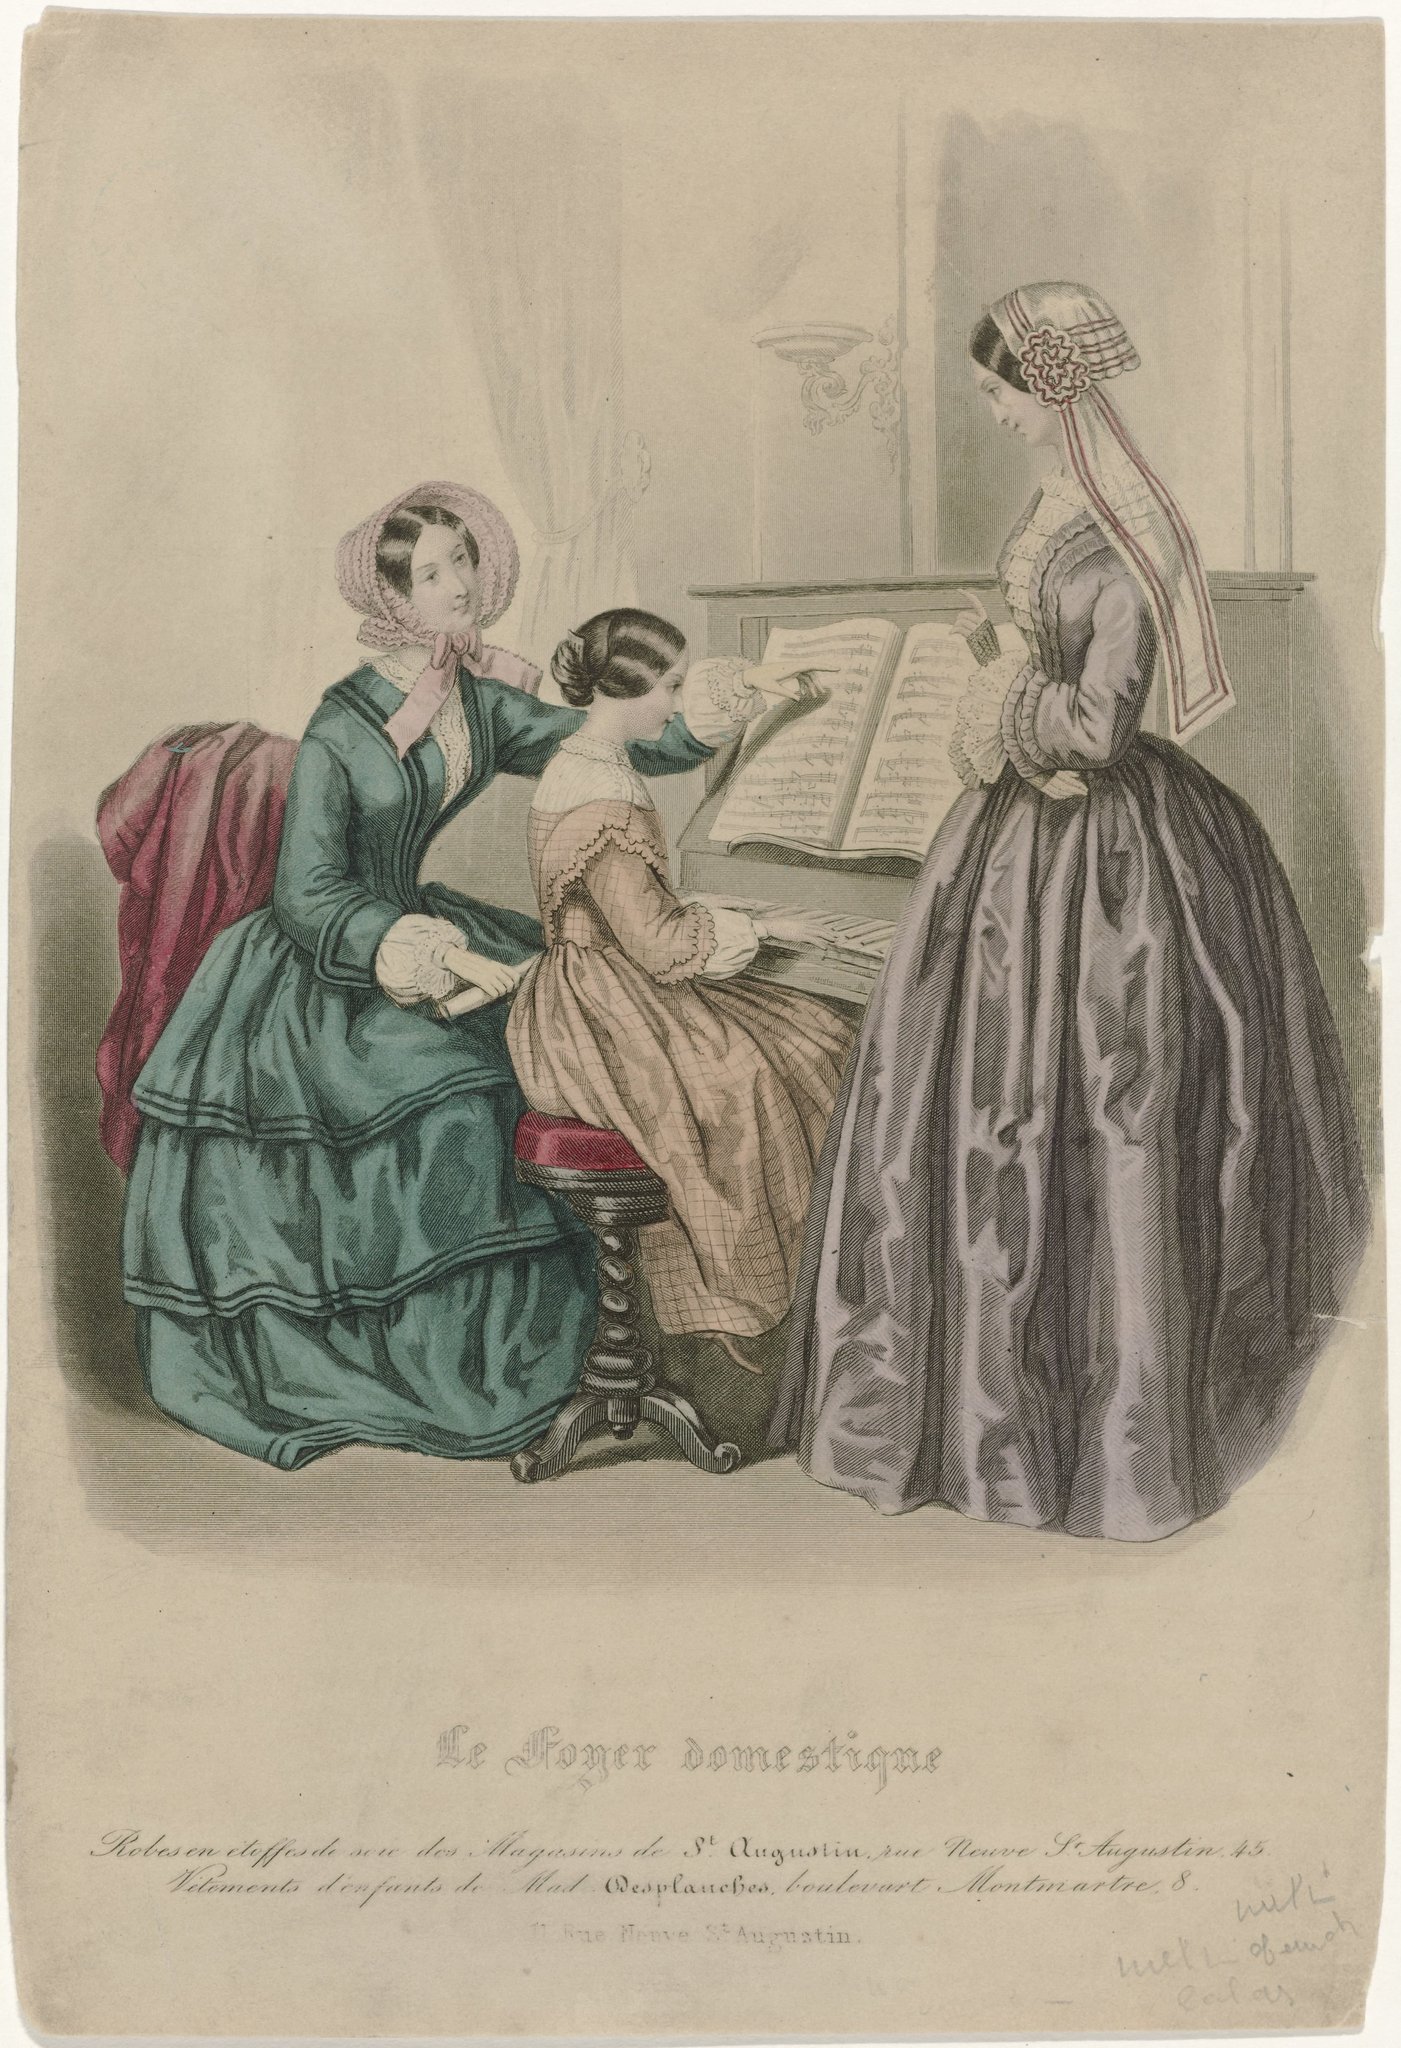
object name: fashion print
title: Le Foyer domestique, ca. 1850 : Robes en etoffes de soi (...)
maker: Anonymous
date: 1850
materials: paper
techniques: engraving, hand coloring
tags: one person playing keyboard instrument, notation of music, clothes, costume (+ girls' clothes), head-gear (+ women's clothes), fashion plates, gloves, mittens, etc. (+ women's clothes), neck-gear ~ clothing (+ women's clothes), pianoforte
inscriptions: title: ‘Le Foyer domestique’, caption: ‘Robes en etoffes de soie des Magasins de S.t Augustin. rue Neuve S.t Augustin, 45. Vétements d'enfants de Mad. Desplanches, boulevart Montmartre, 8.’, address: ‘11 Rue Neuve S.t Augustin’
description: Interieur met meisje achter de piano en twee dames. Volgens het onderschrift dragen zij japonnen van zijde uit de winkels van St. Augustin. De kinderkleding is van Madame Desplanches.